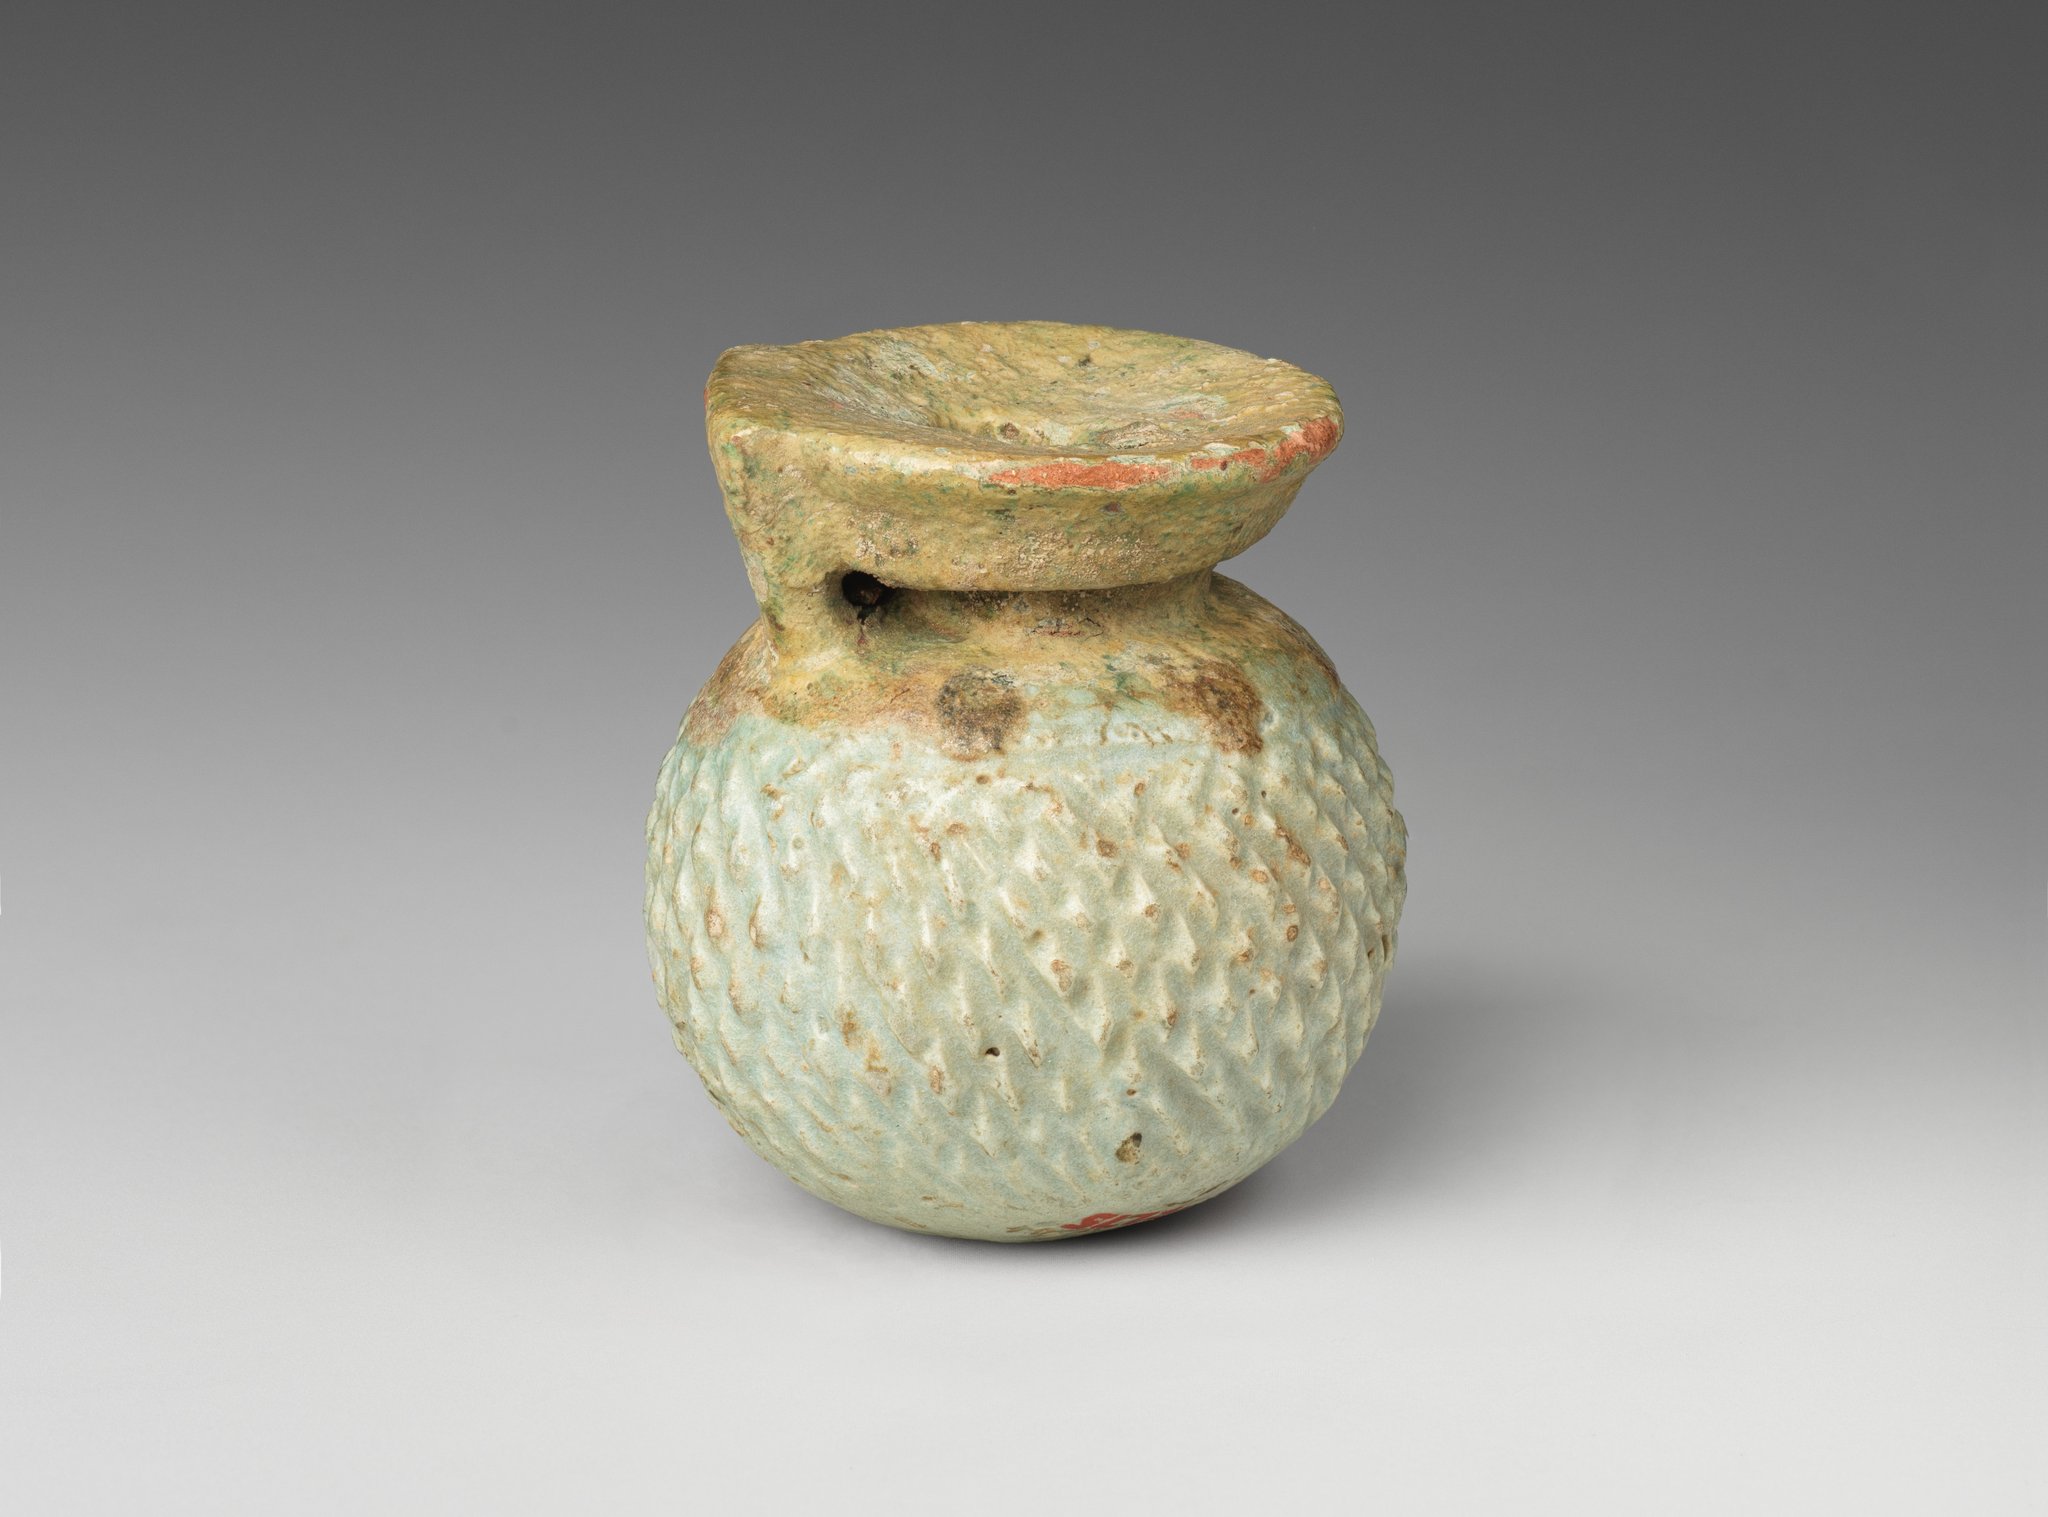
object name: jug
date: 600-501 BCE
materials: faience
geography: egypt